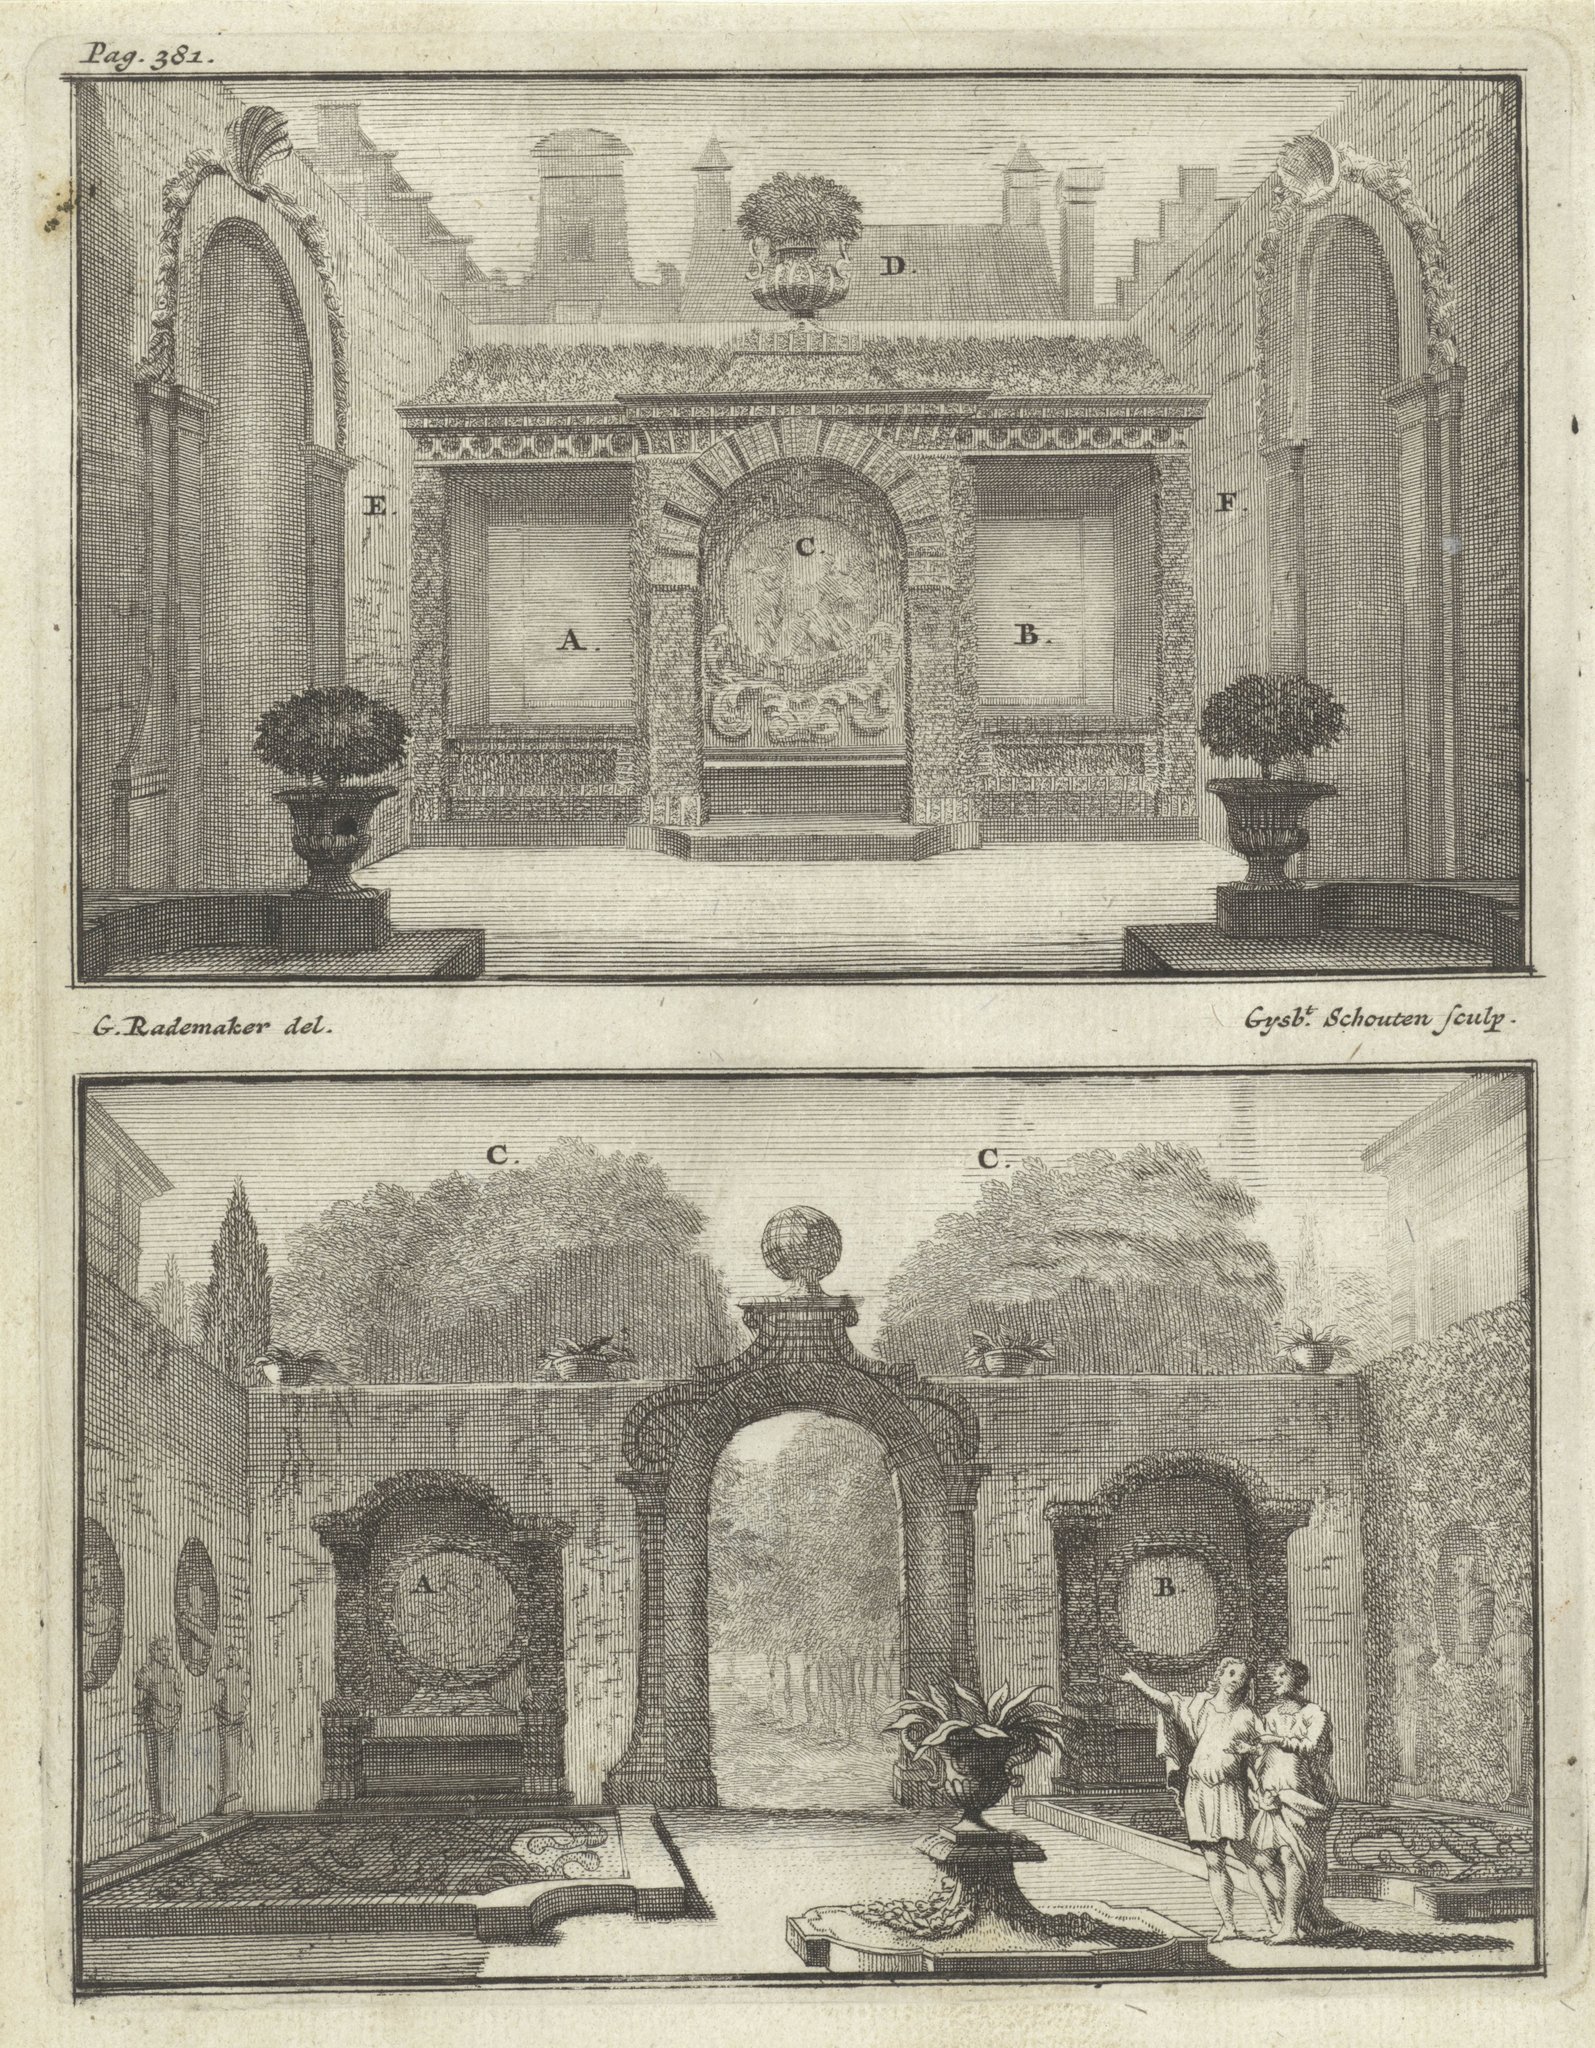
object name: book illustration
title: Illustraties met tuinontwerpen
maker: gerrit rademaker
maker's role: draughtsman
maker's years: 1671-1711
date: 1706-1722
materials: paper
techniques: etching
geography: netherlands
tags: french or architectonic garden; formal garden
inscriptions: collector's mark: Lugt 2760, collector's mark: Lugt 2166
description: Twee illustraties boven elkaar. Boven: de inrichting van een ommuurde tuin. Onder: twee figuren in een tuin met een poort. Linksboven: pag. 381.